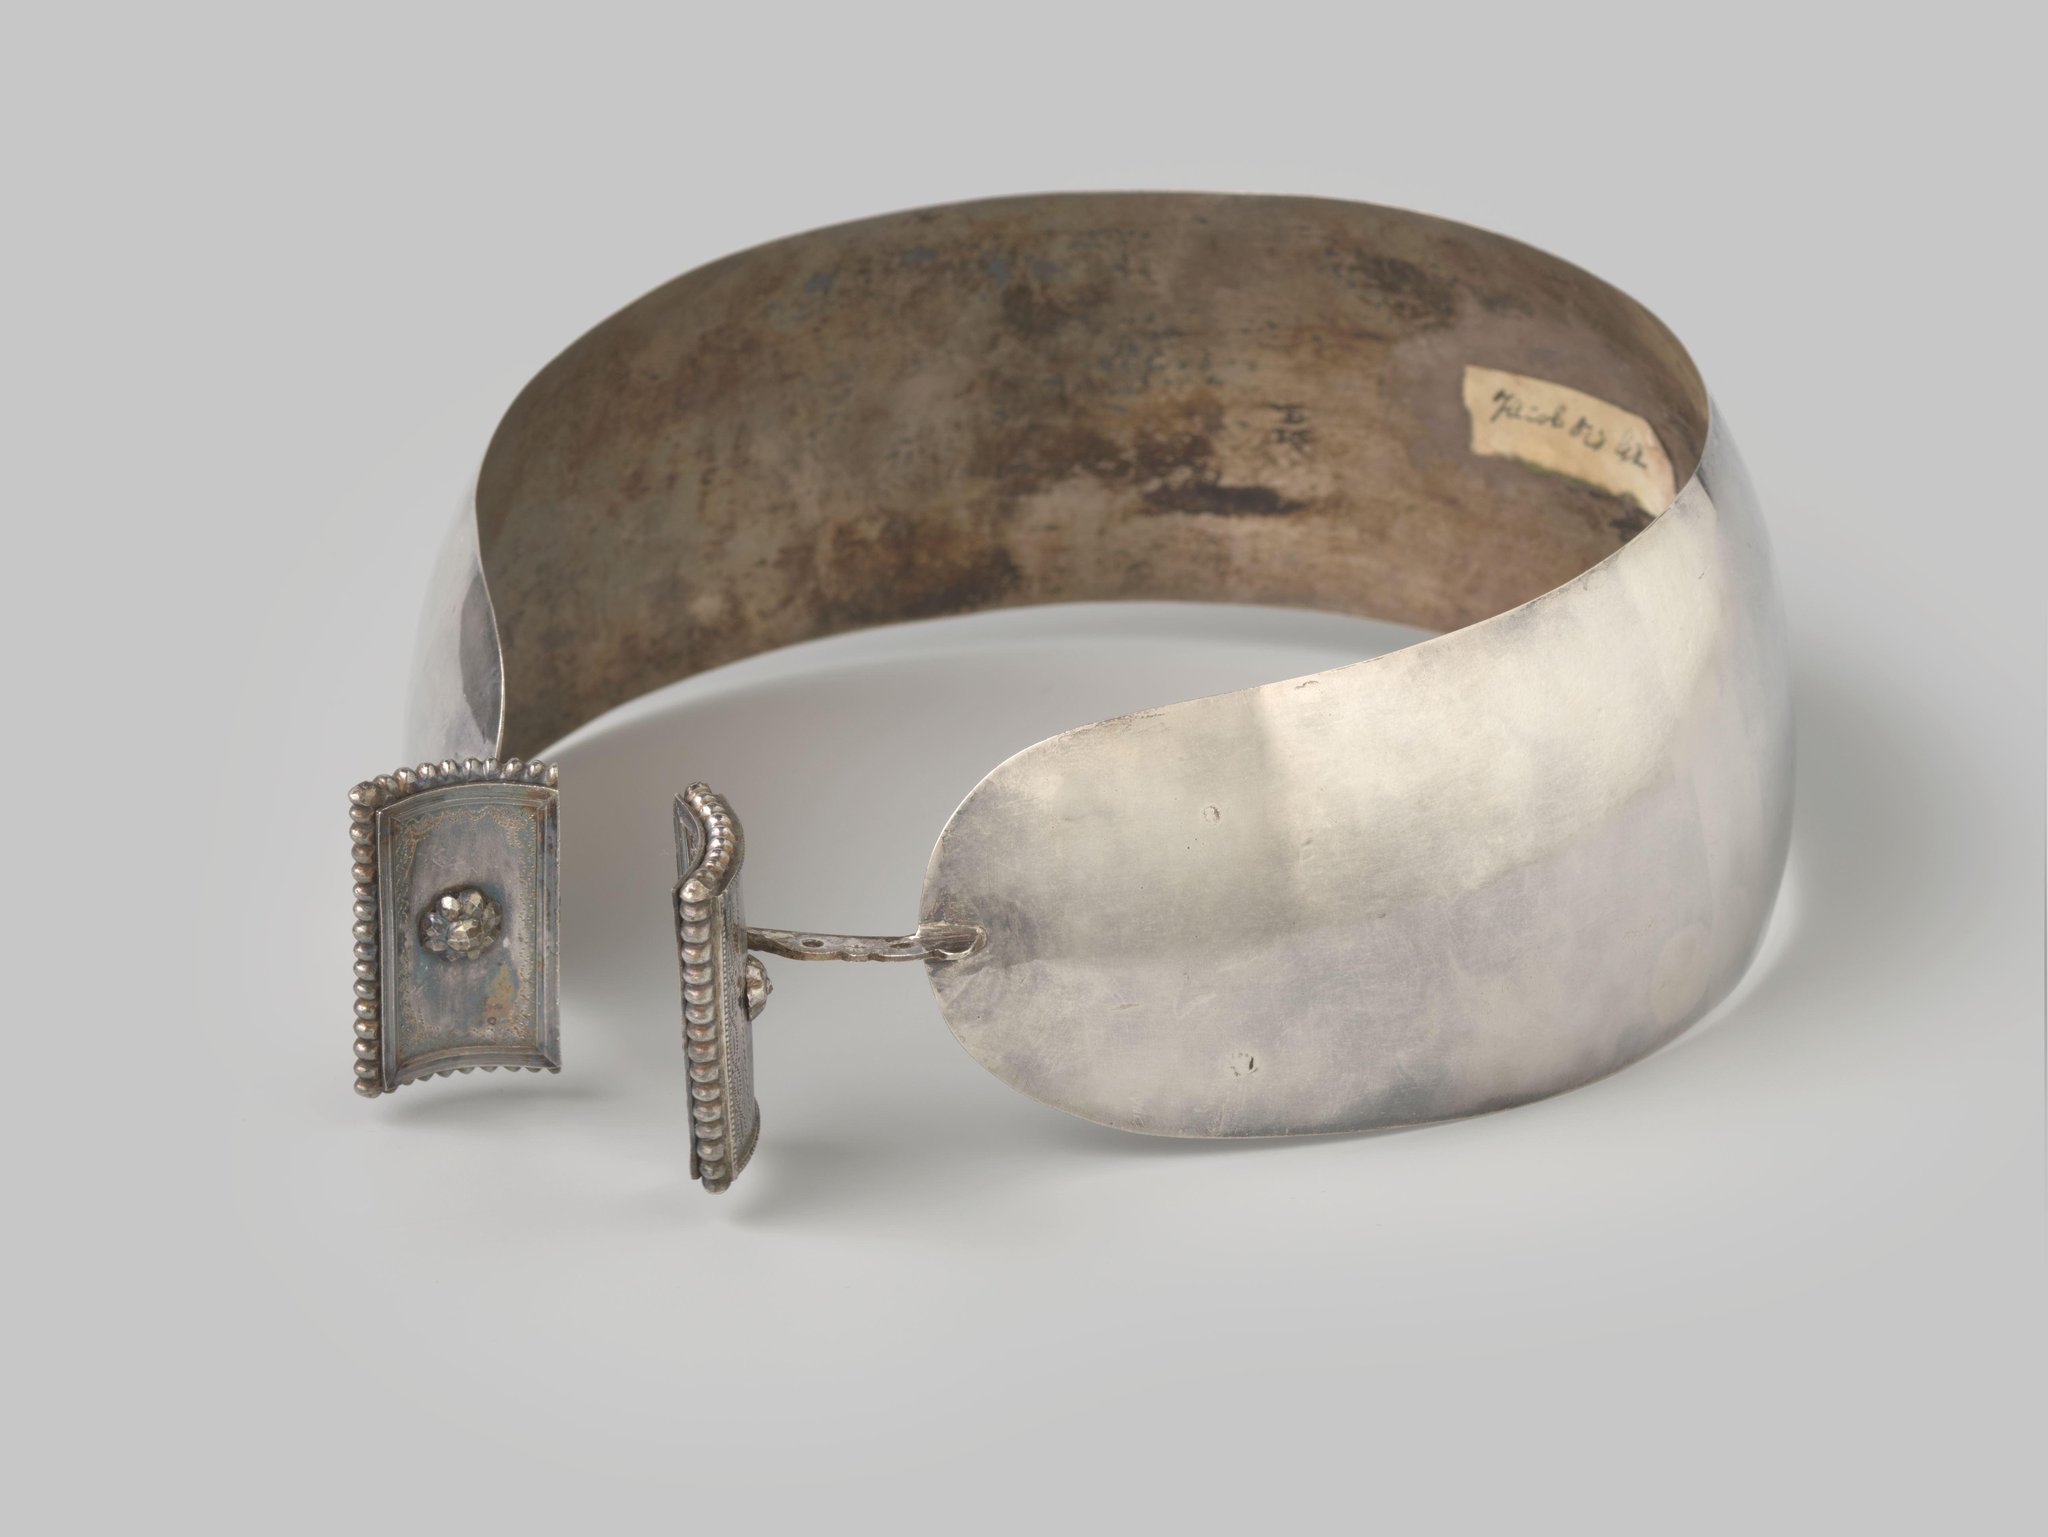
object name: womenswear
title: Kap van zilver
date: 1785-1800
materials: silver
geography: zaanstreek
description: Kap van zilver, gevormd door een concave band voorzien van twee rechthoekige zilveren plaatjes met parelranden en rozet. Onderdeel van een kapstel.